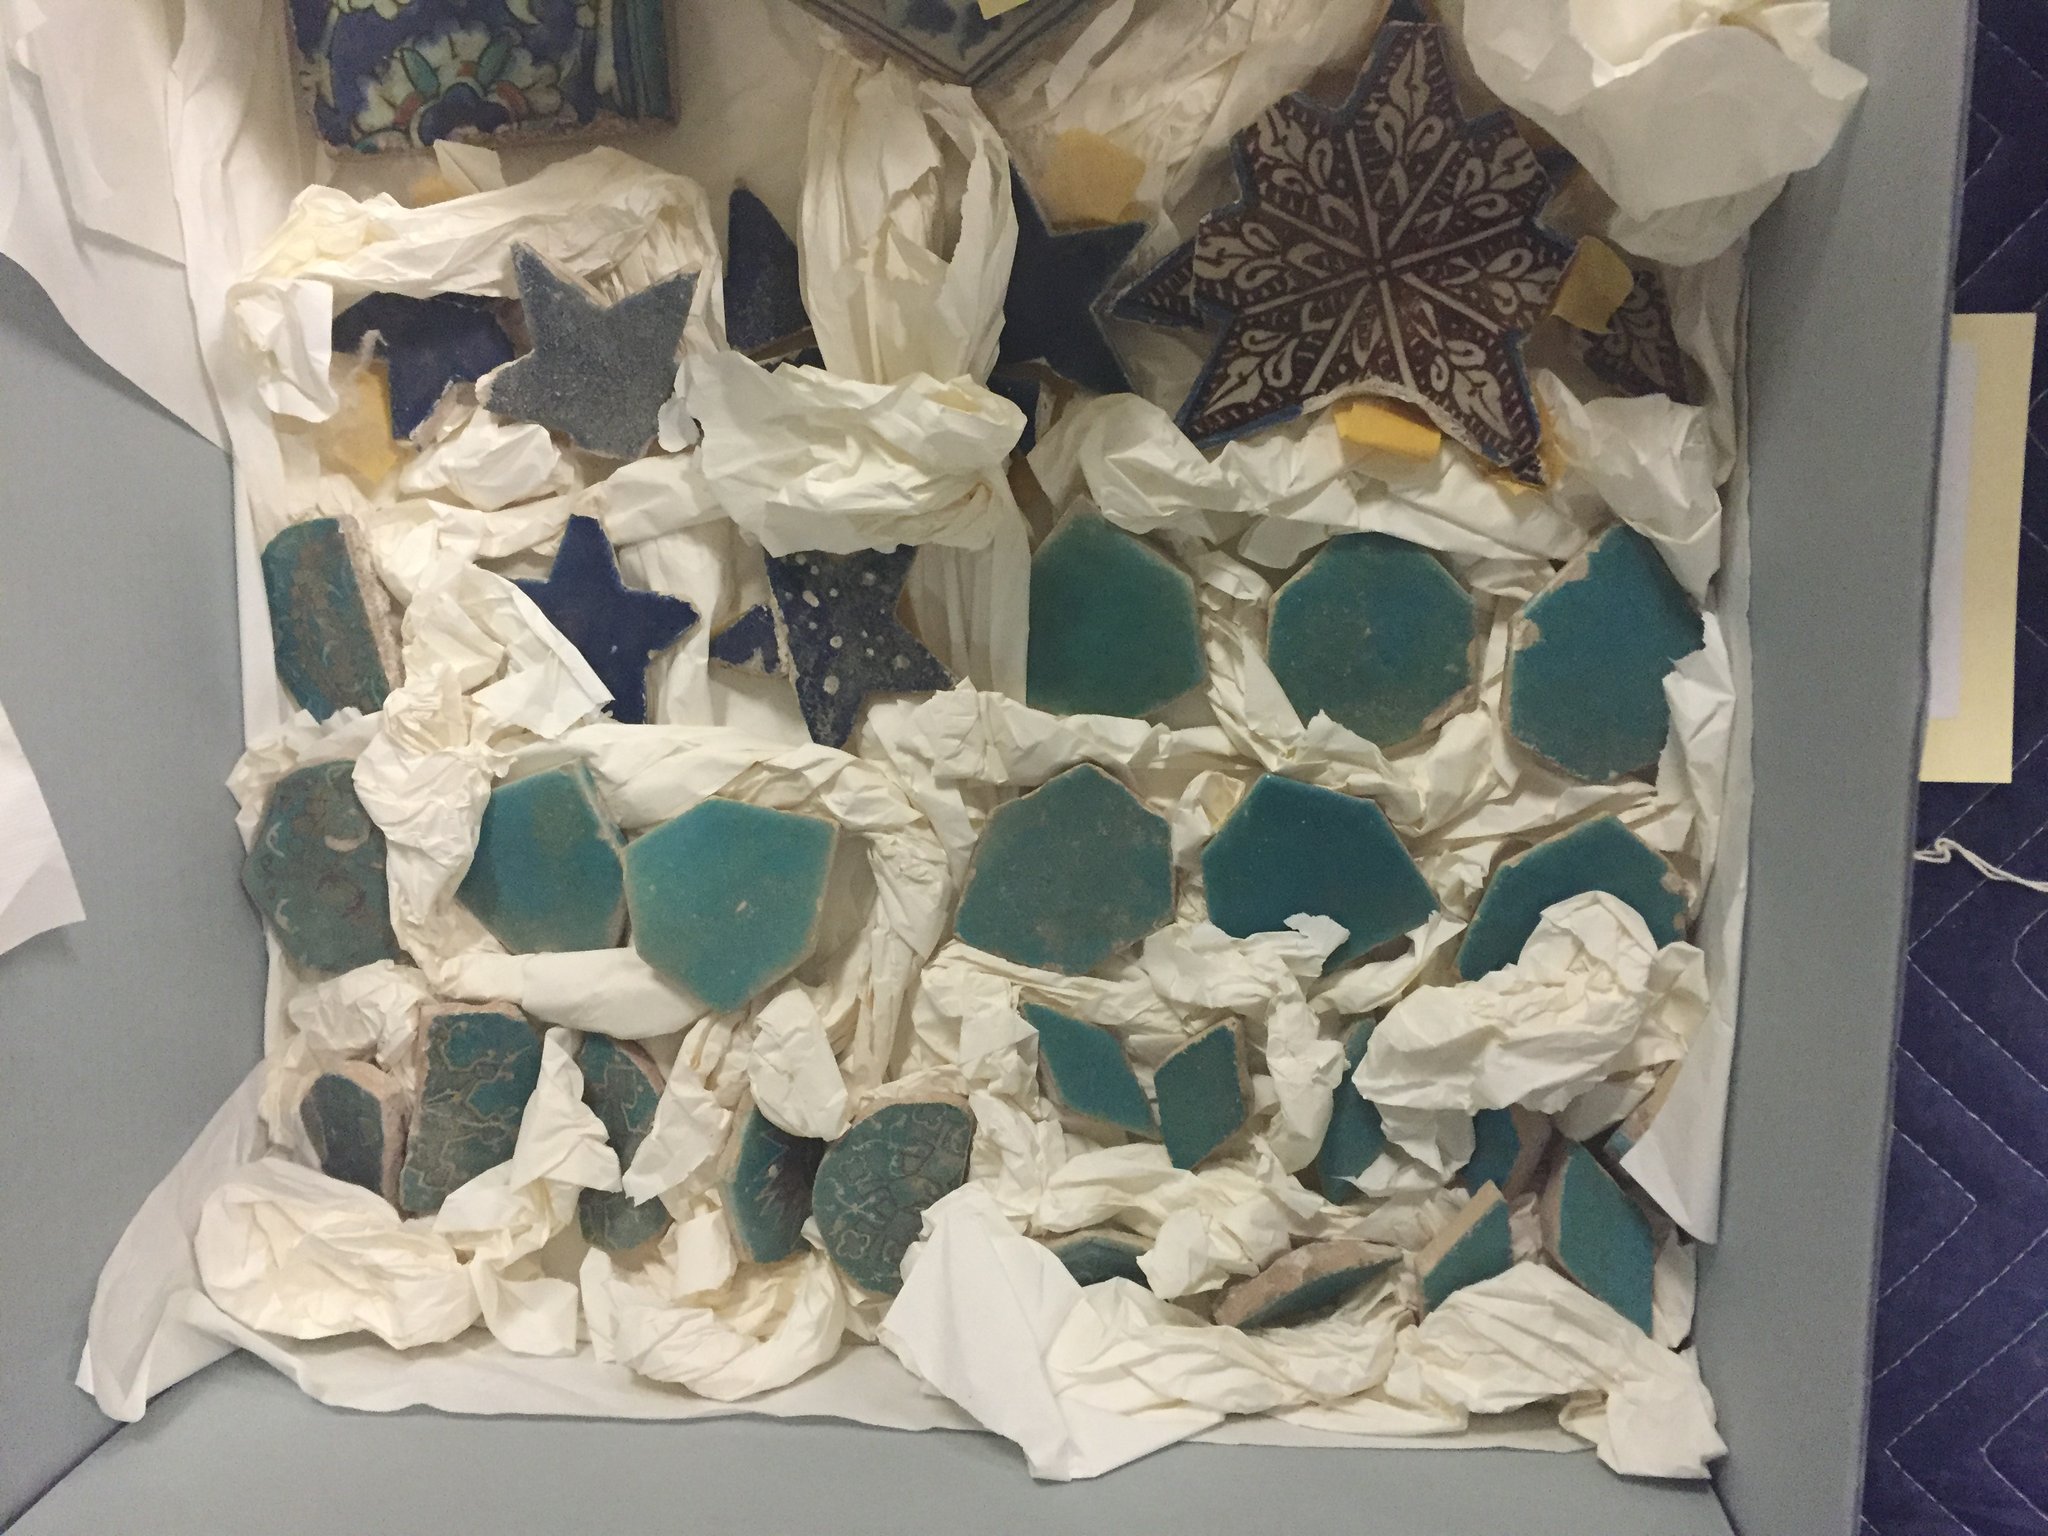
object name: tile panel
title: Fragments of a Tile Panel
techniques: cutting, glazing, polychrome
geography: iran